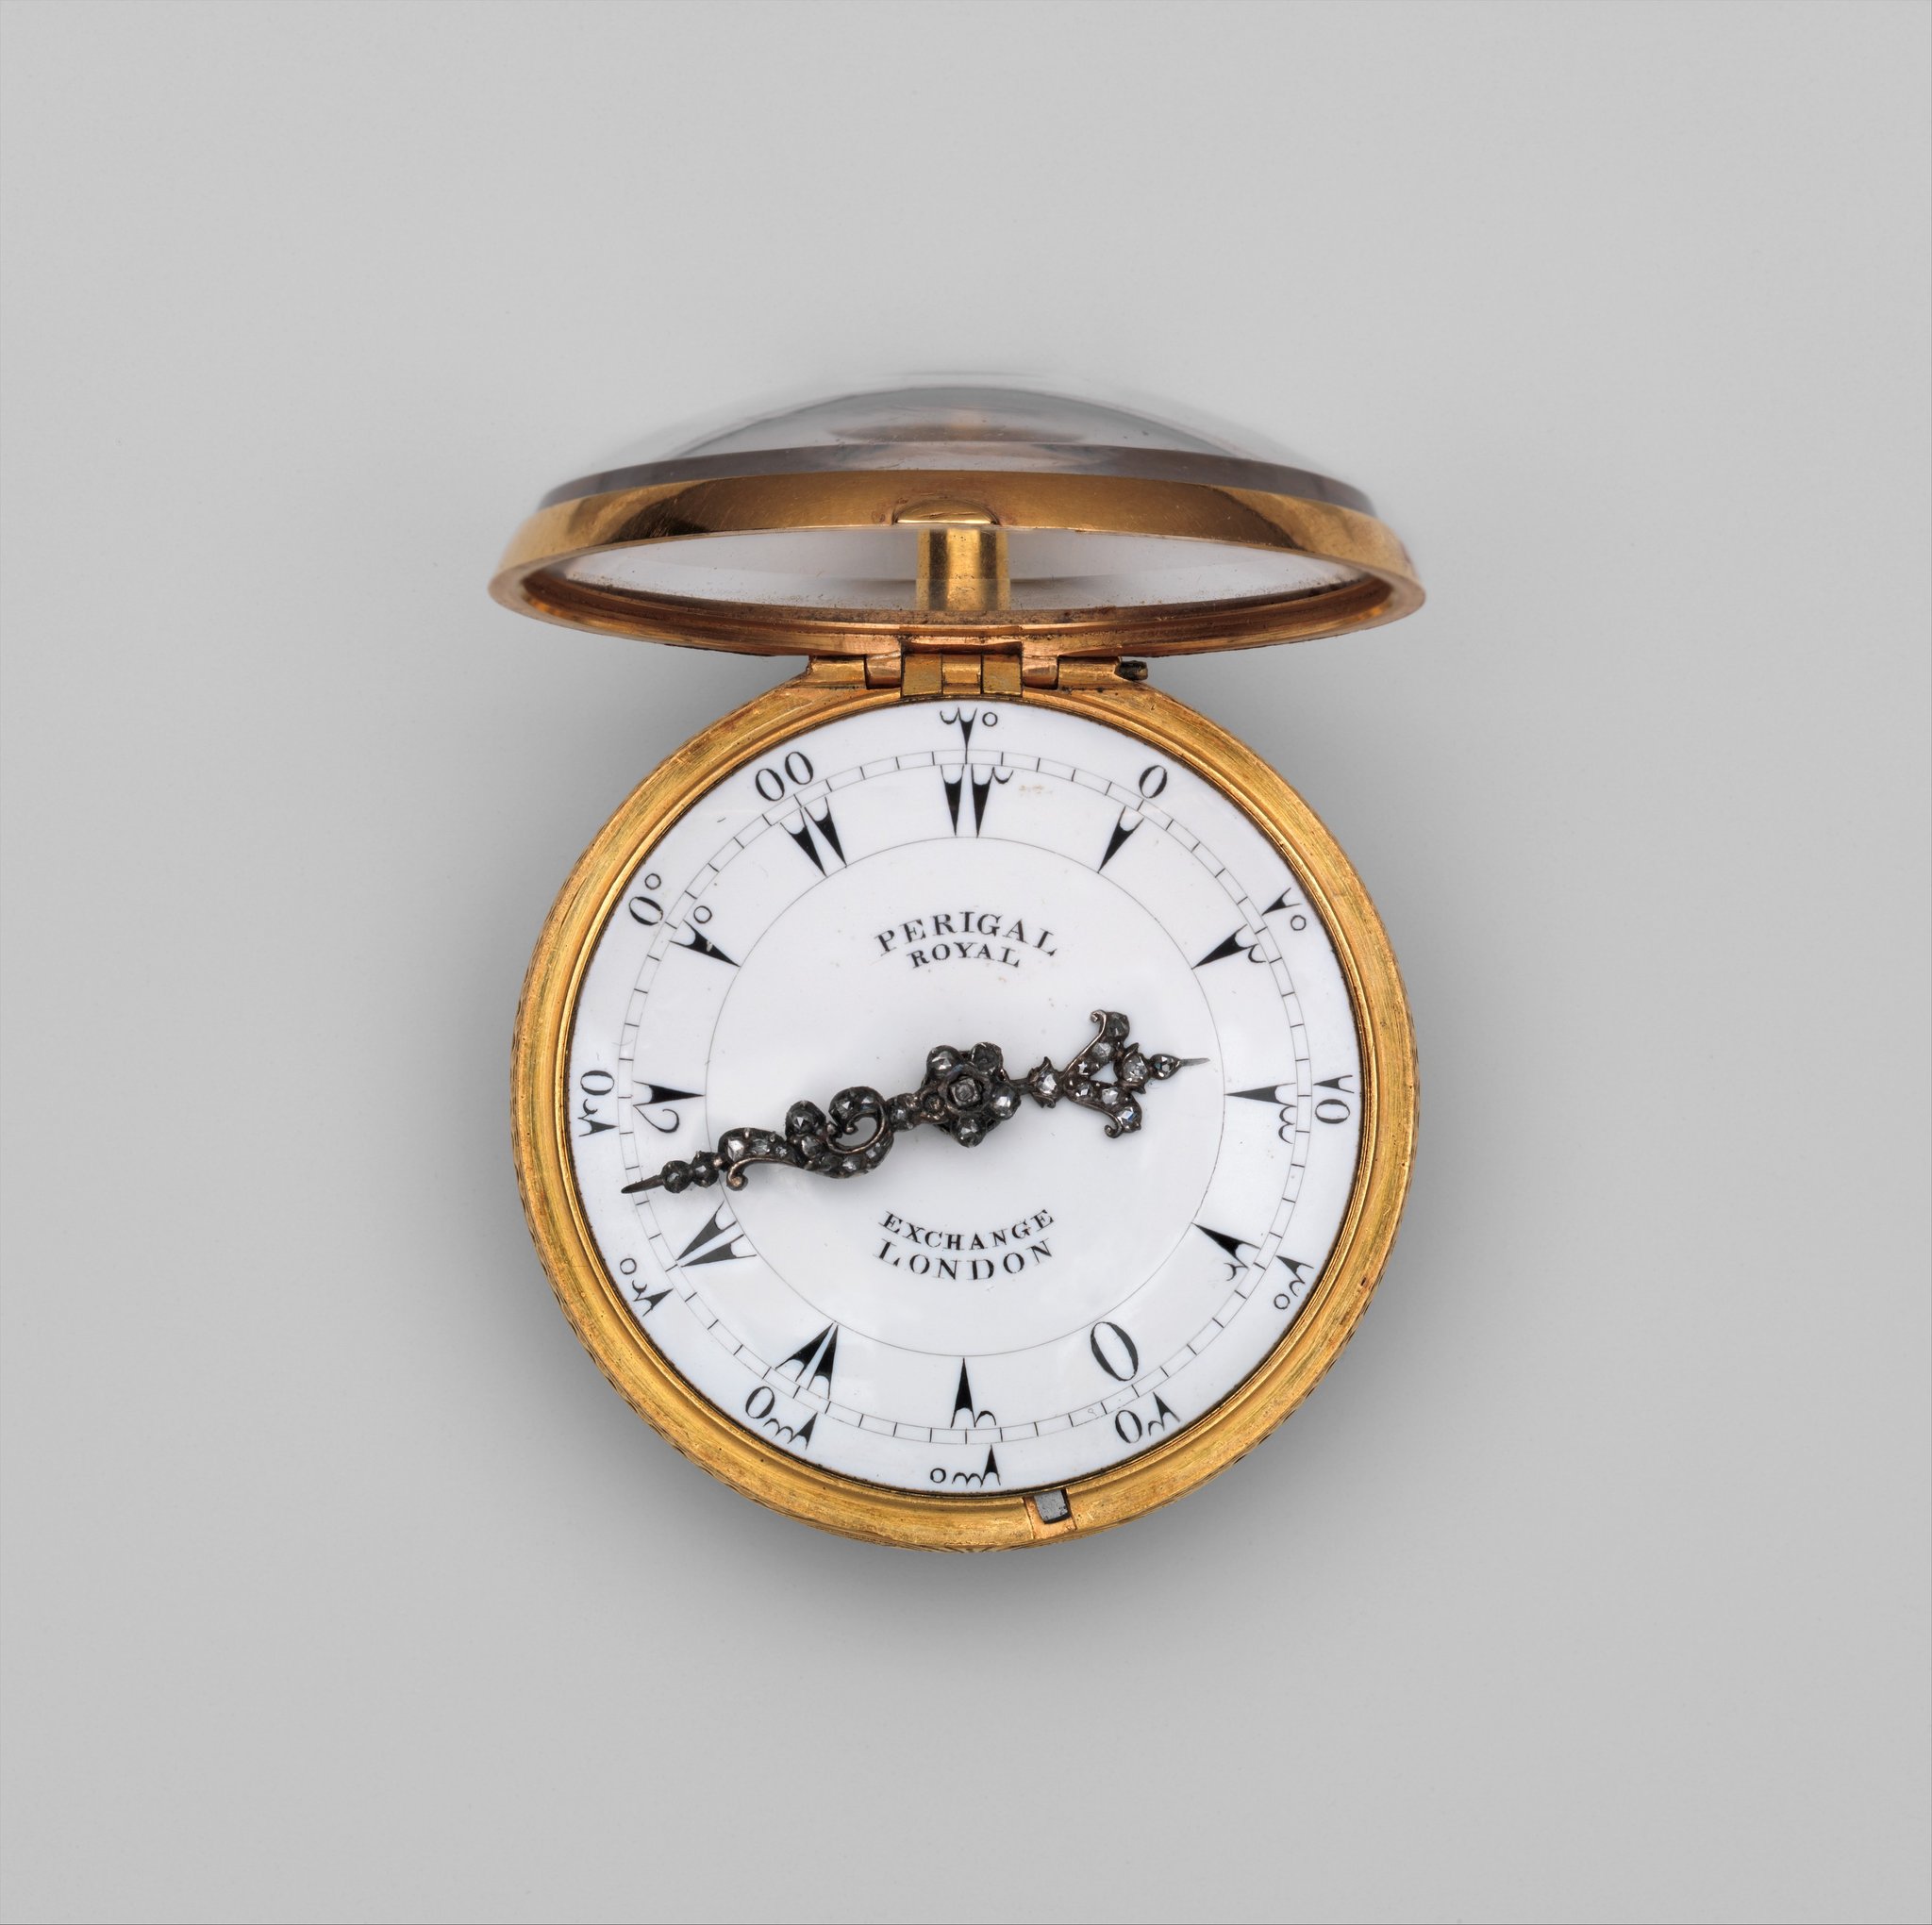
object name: repeating watch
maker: francis perigal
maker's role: maker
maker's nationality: british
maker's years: 1741-1767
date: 1770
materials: diamond, enamel, gilt brass, gold, silver, steel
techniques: enamel